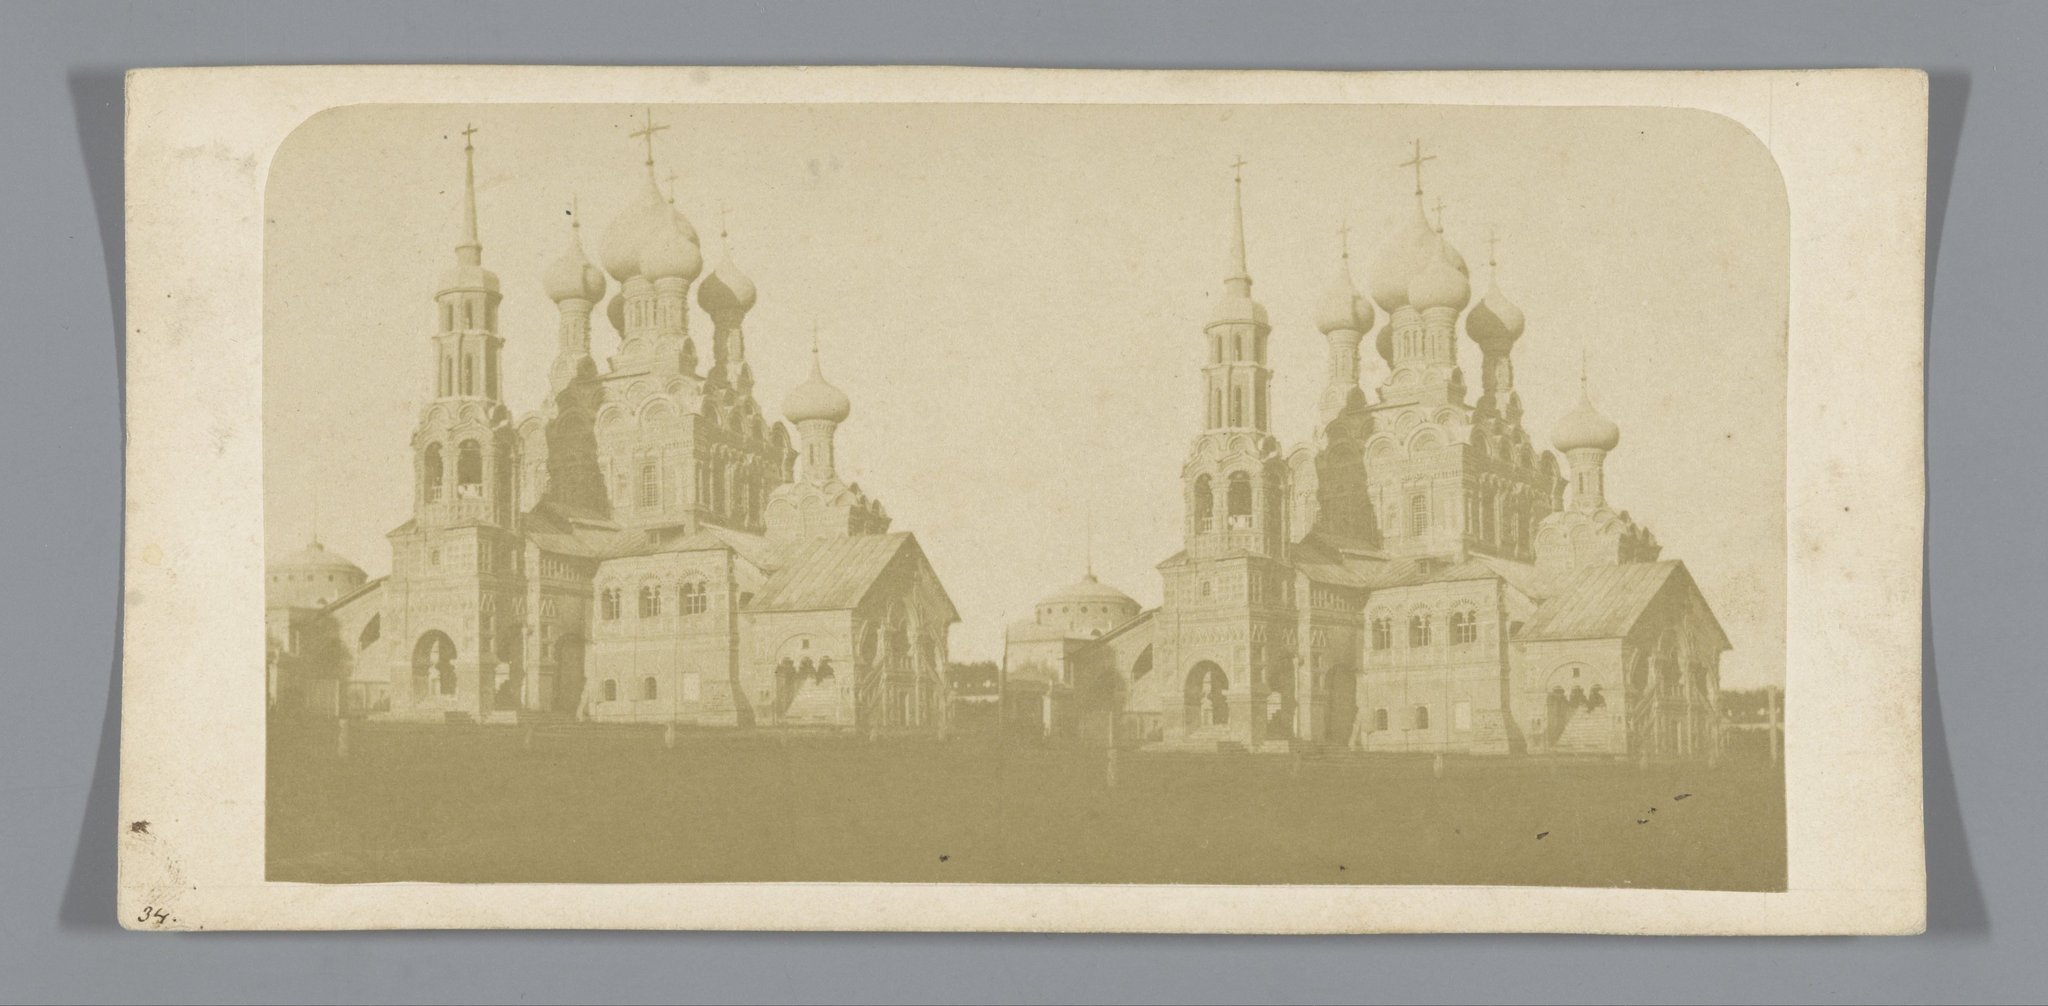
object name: stereograph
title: Gezicht op de Drie-eenheidskerk in Ostankino te Moskou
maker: Anonymous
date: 1850-1880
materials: cardboard, photographic support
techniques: albumen print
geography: moscow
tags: tower, clock tower ~ monumental adornment, church (exterior)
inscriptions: inscription: ‘Eglise a Ostankino’, inscription: ‘D. 14.’, number: ‘34.’